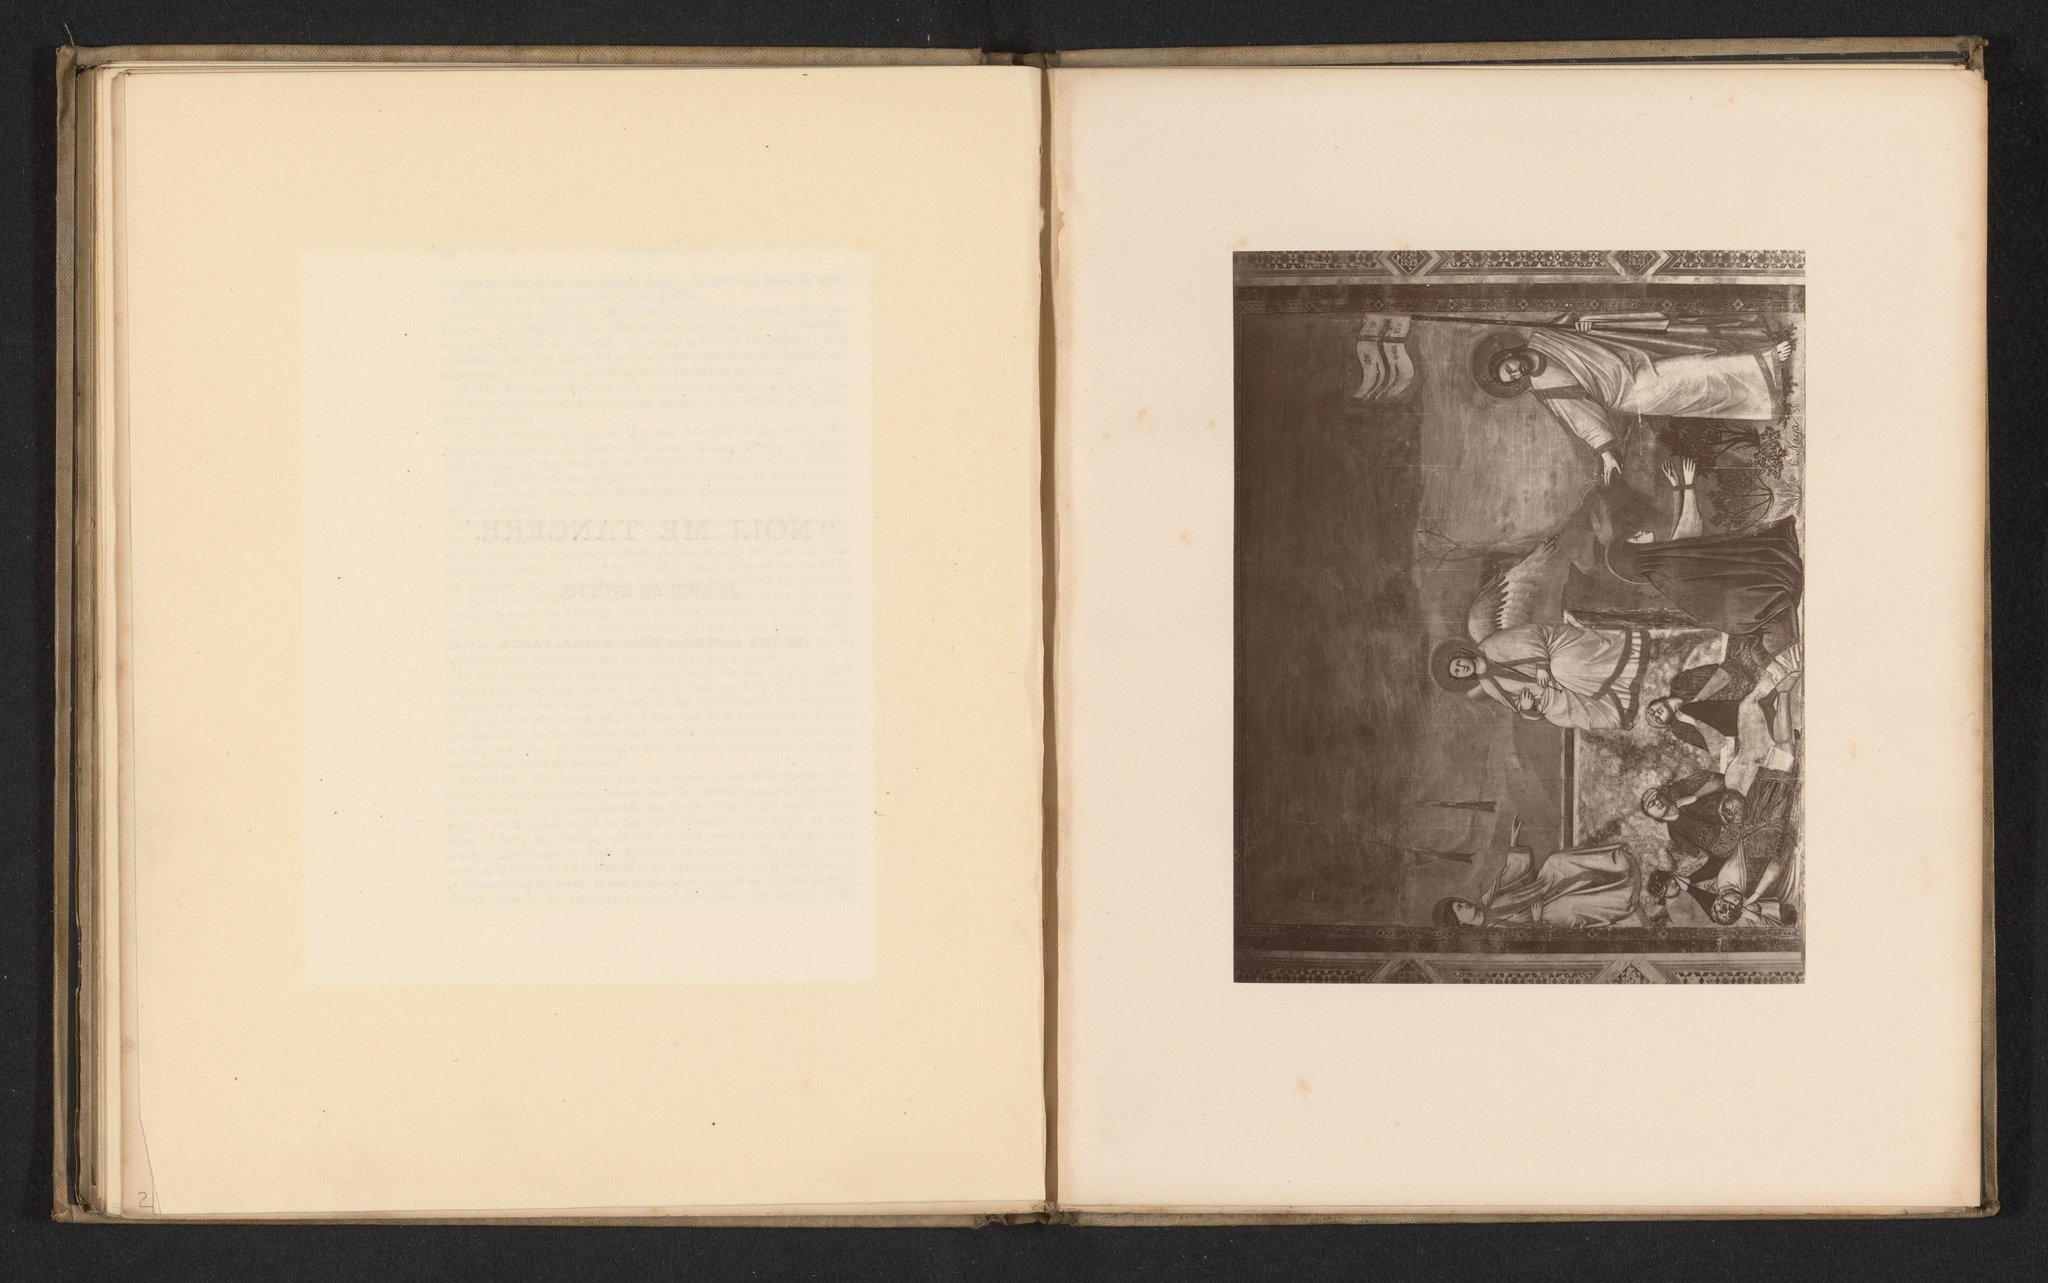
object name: page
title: Fotoreproductie van een fresco, voorstellende Christus verschijnt als tuinman aan Maria Magdalena (noli me tangere)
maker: Anonymous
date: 1870-1880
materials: paper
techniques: woodburytype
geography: padua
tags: mary magdalene kneeling before christ, who is usually represented as a gardener with a hoe and/or a spade; 'noli me tangere', angels